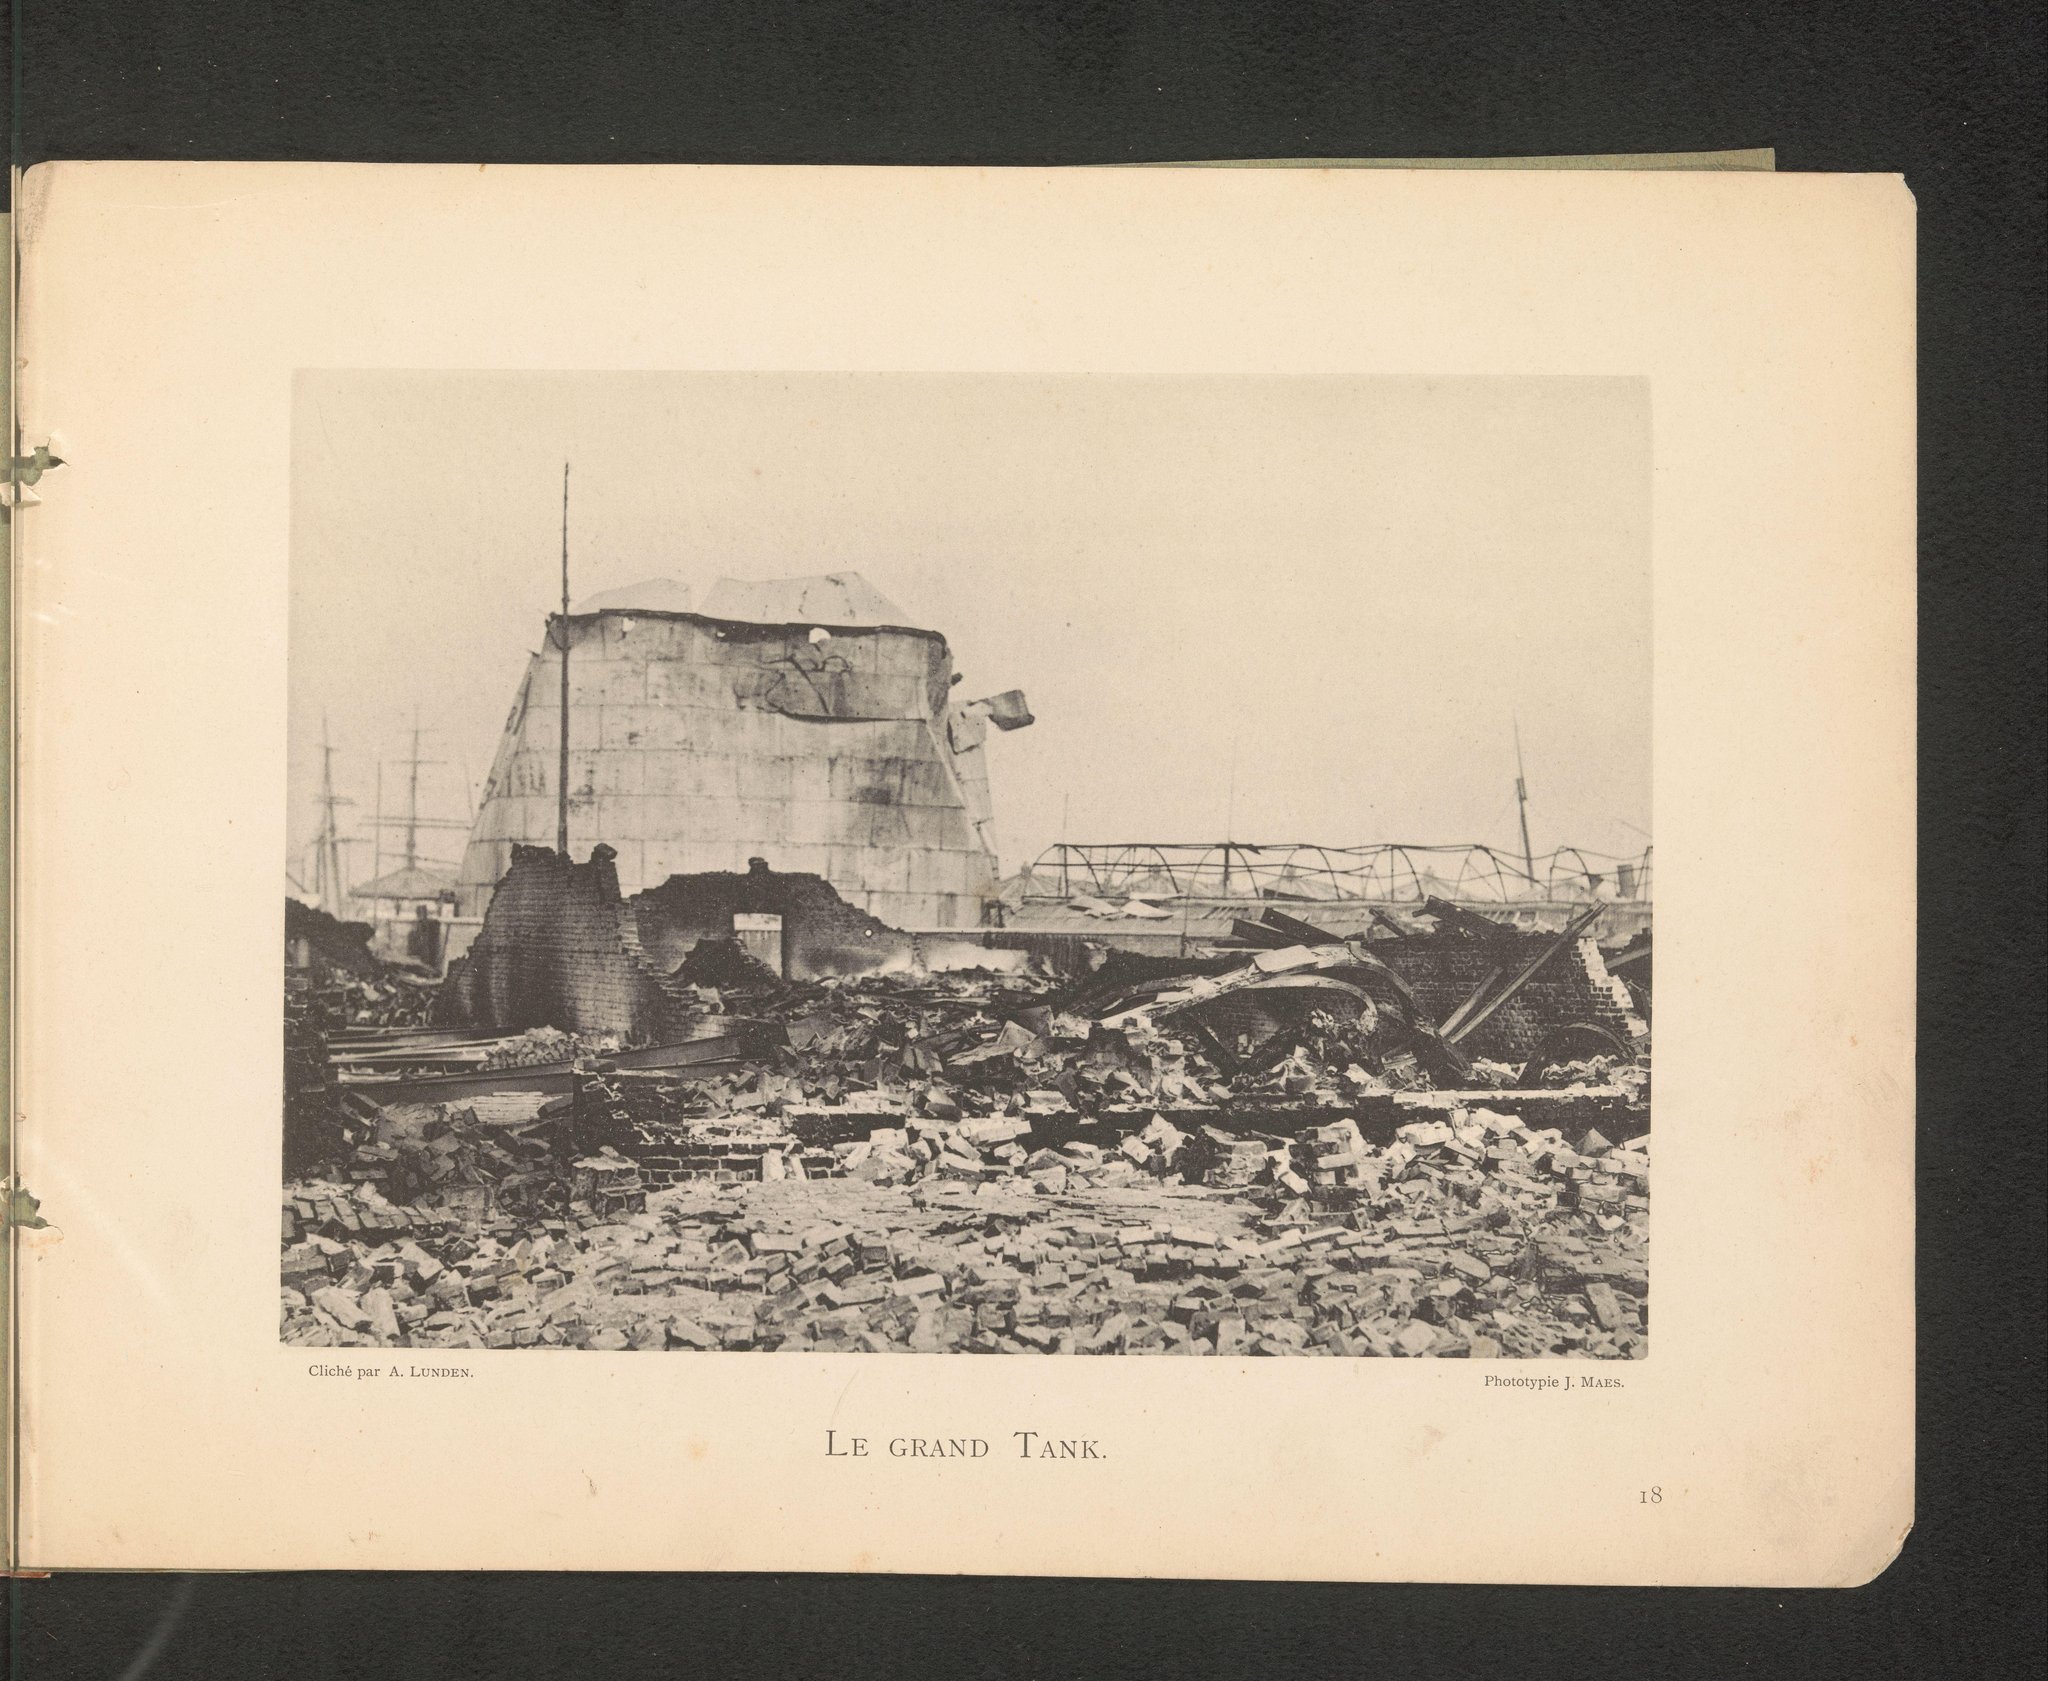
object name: photomechanical print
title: Resten van een grote tank na de ontploffing van een munitiefabriek in Oosterweel bij Antwerpen op 6 september 1889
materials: paper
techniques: photograph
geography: oosterweel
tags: ruin of a building ~ architecture, oil tanks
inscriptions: number: ‘18’